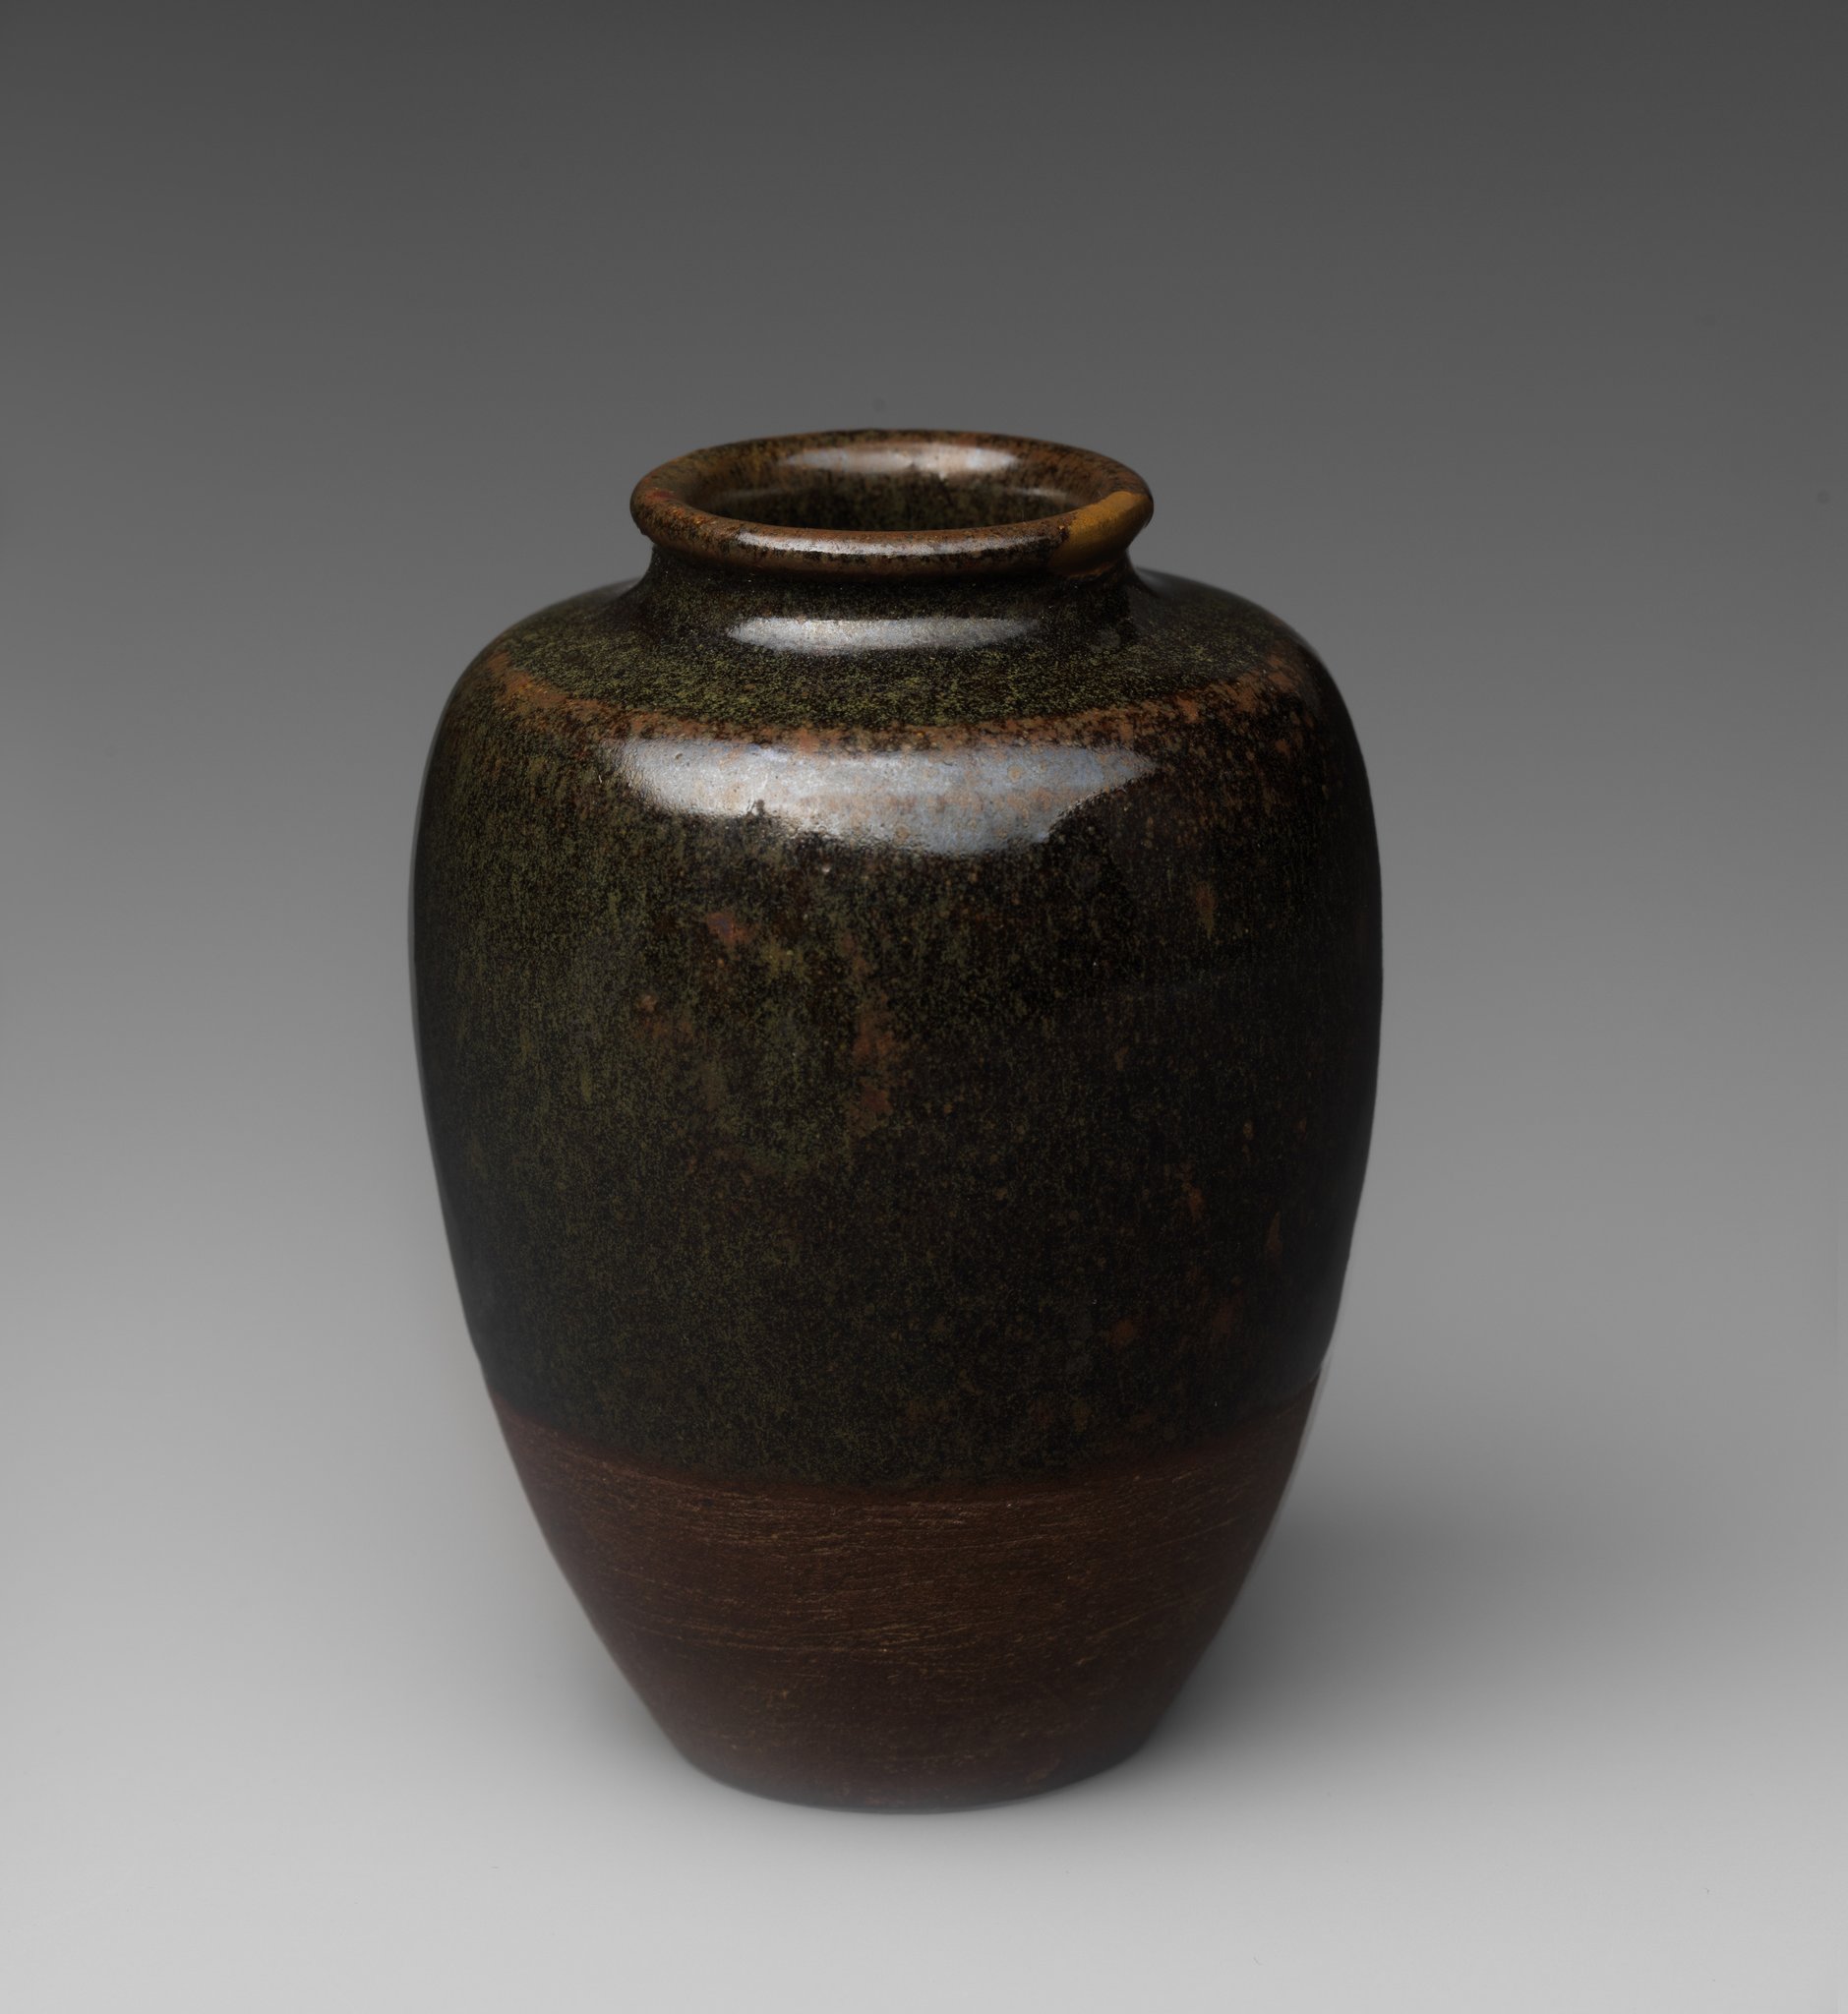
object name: tea jar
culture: japanese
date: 1701-1800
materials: clay, glaze